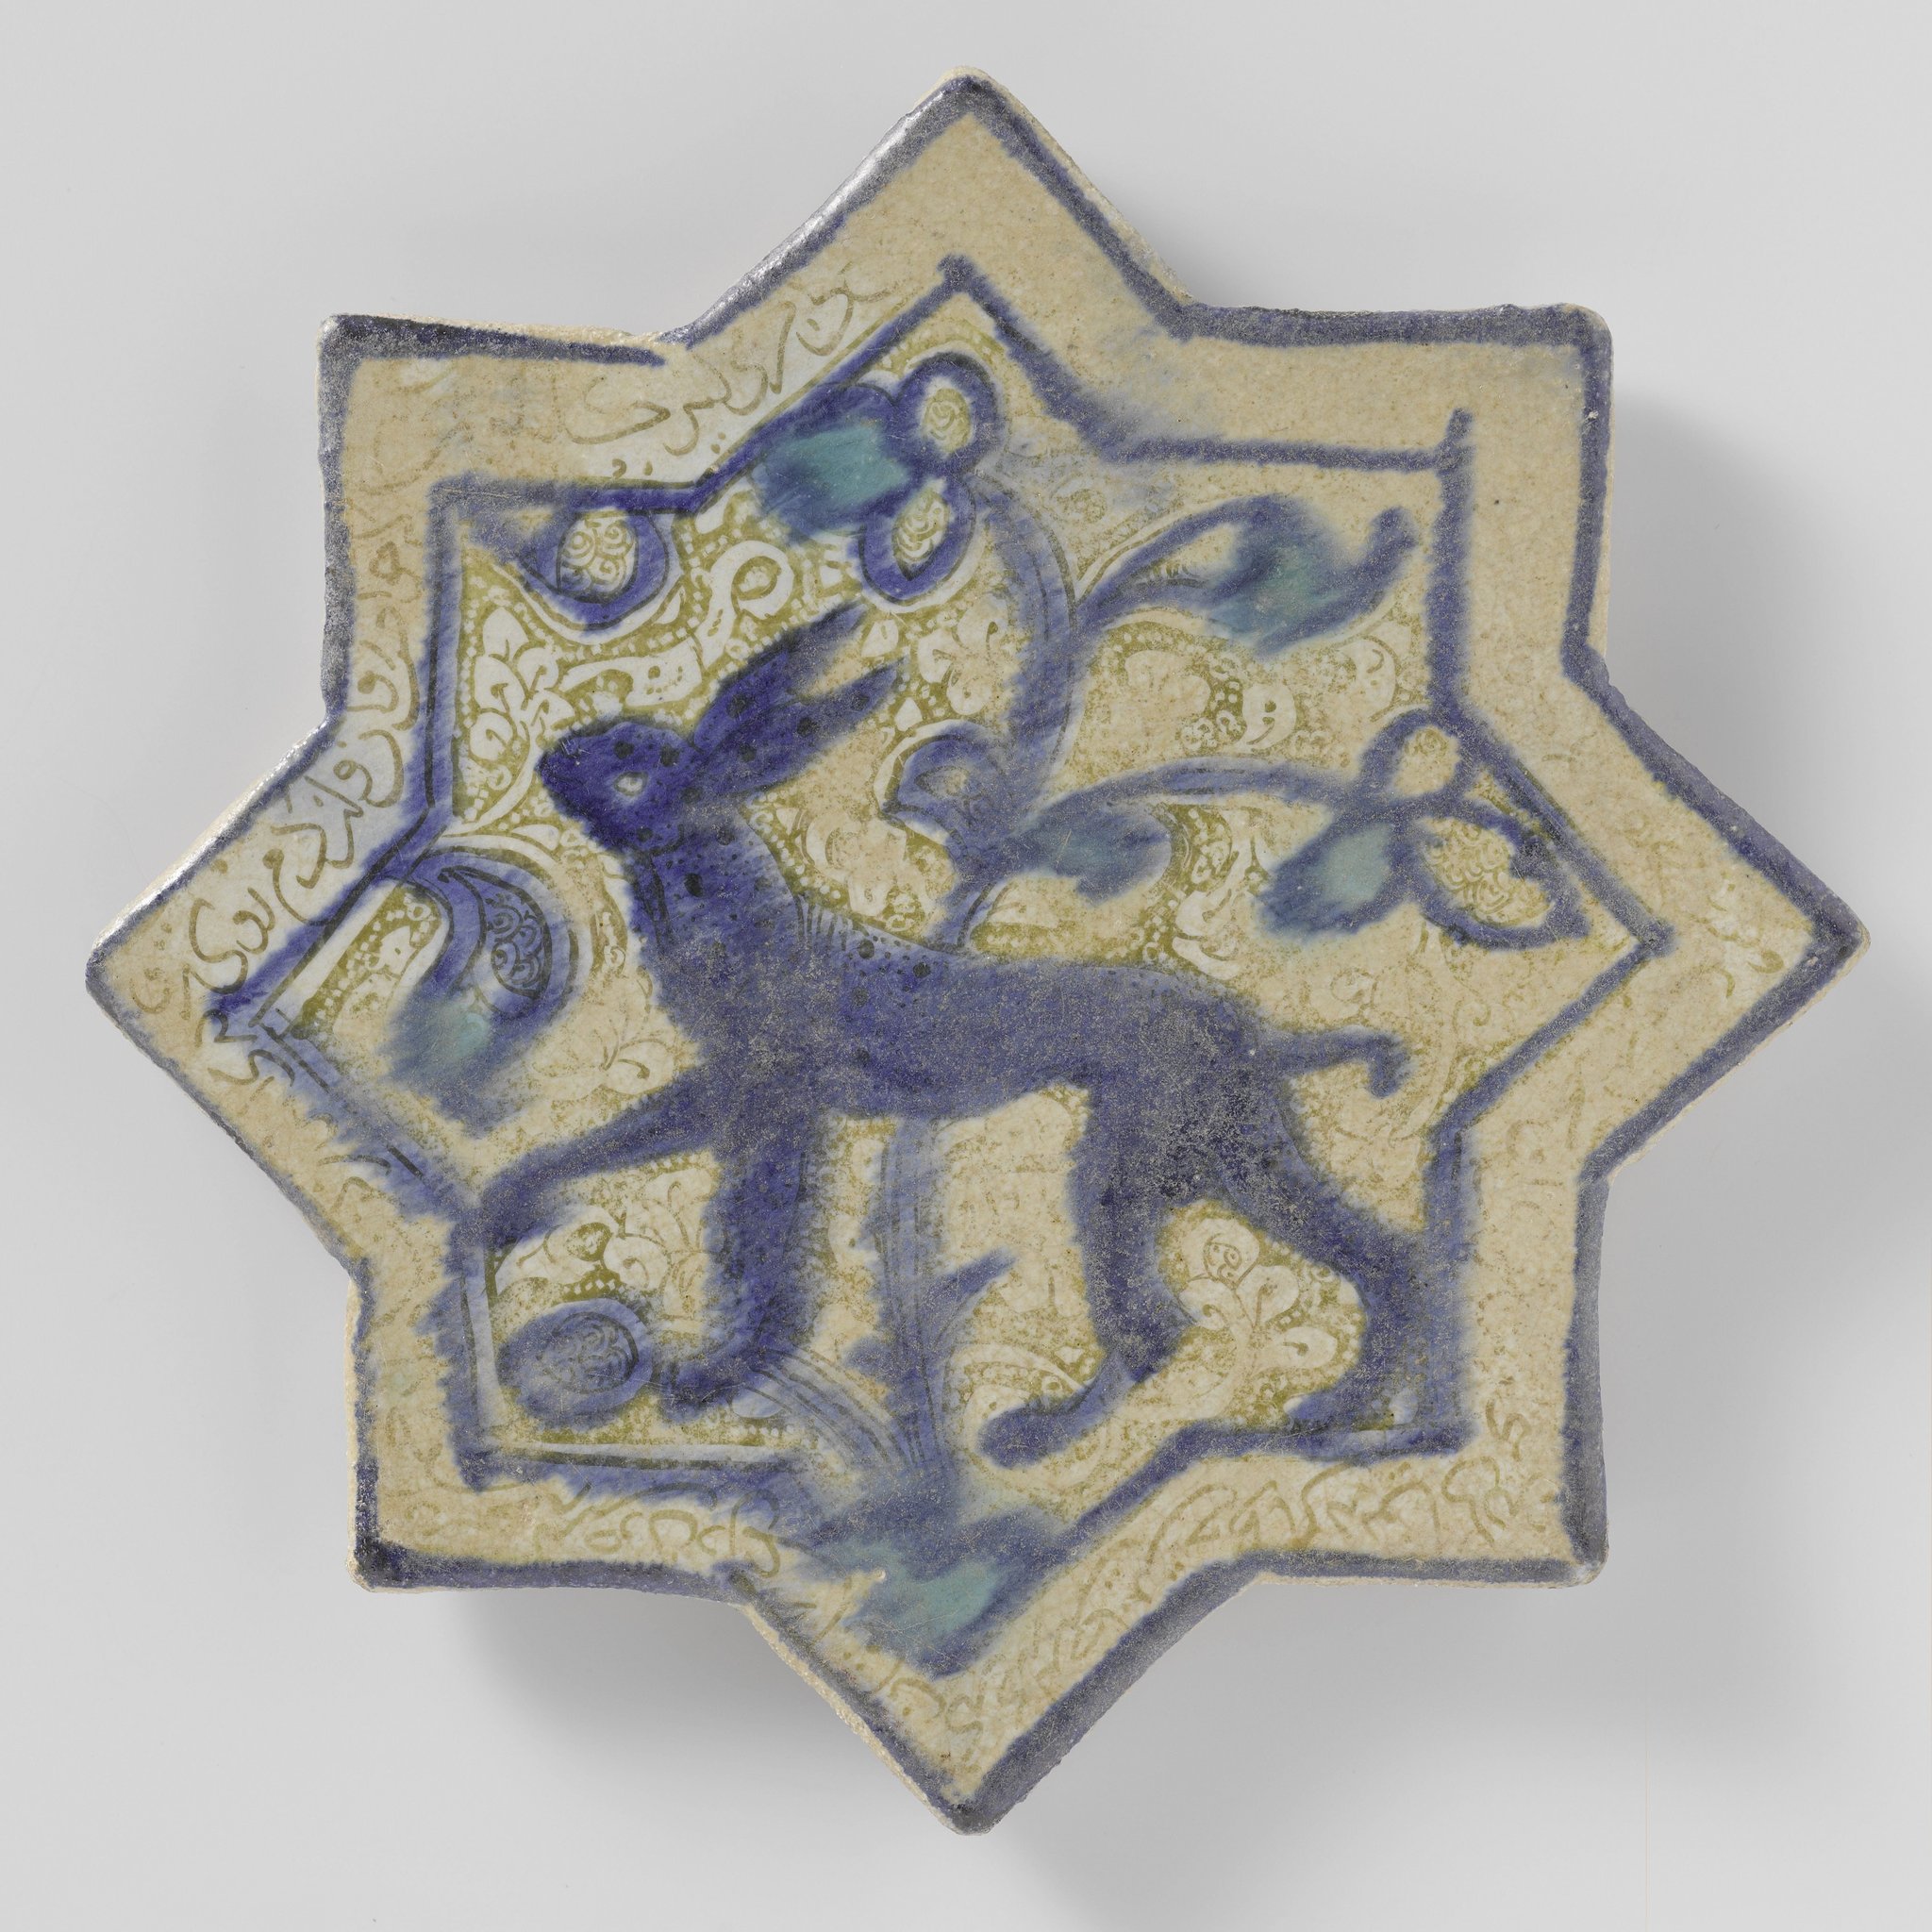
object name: stertegel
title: Tile in the shape of a star with a hare and inscription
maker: Anonymous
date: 1250-1299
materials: earthenware, glaze, luster, paint, quartz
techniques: firing, forming, vitrification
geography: kashan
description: Kwarts-fritgoed stertegel gedecoreerd met schrift, haas en bloemen in groen luster, blauw en turquoise op ondergrond van witte glazuur.